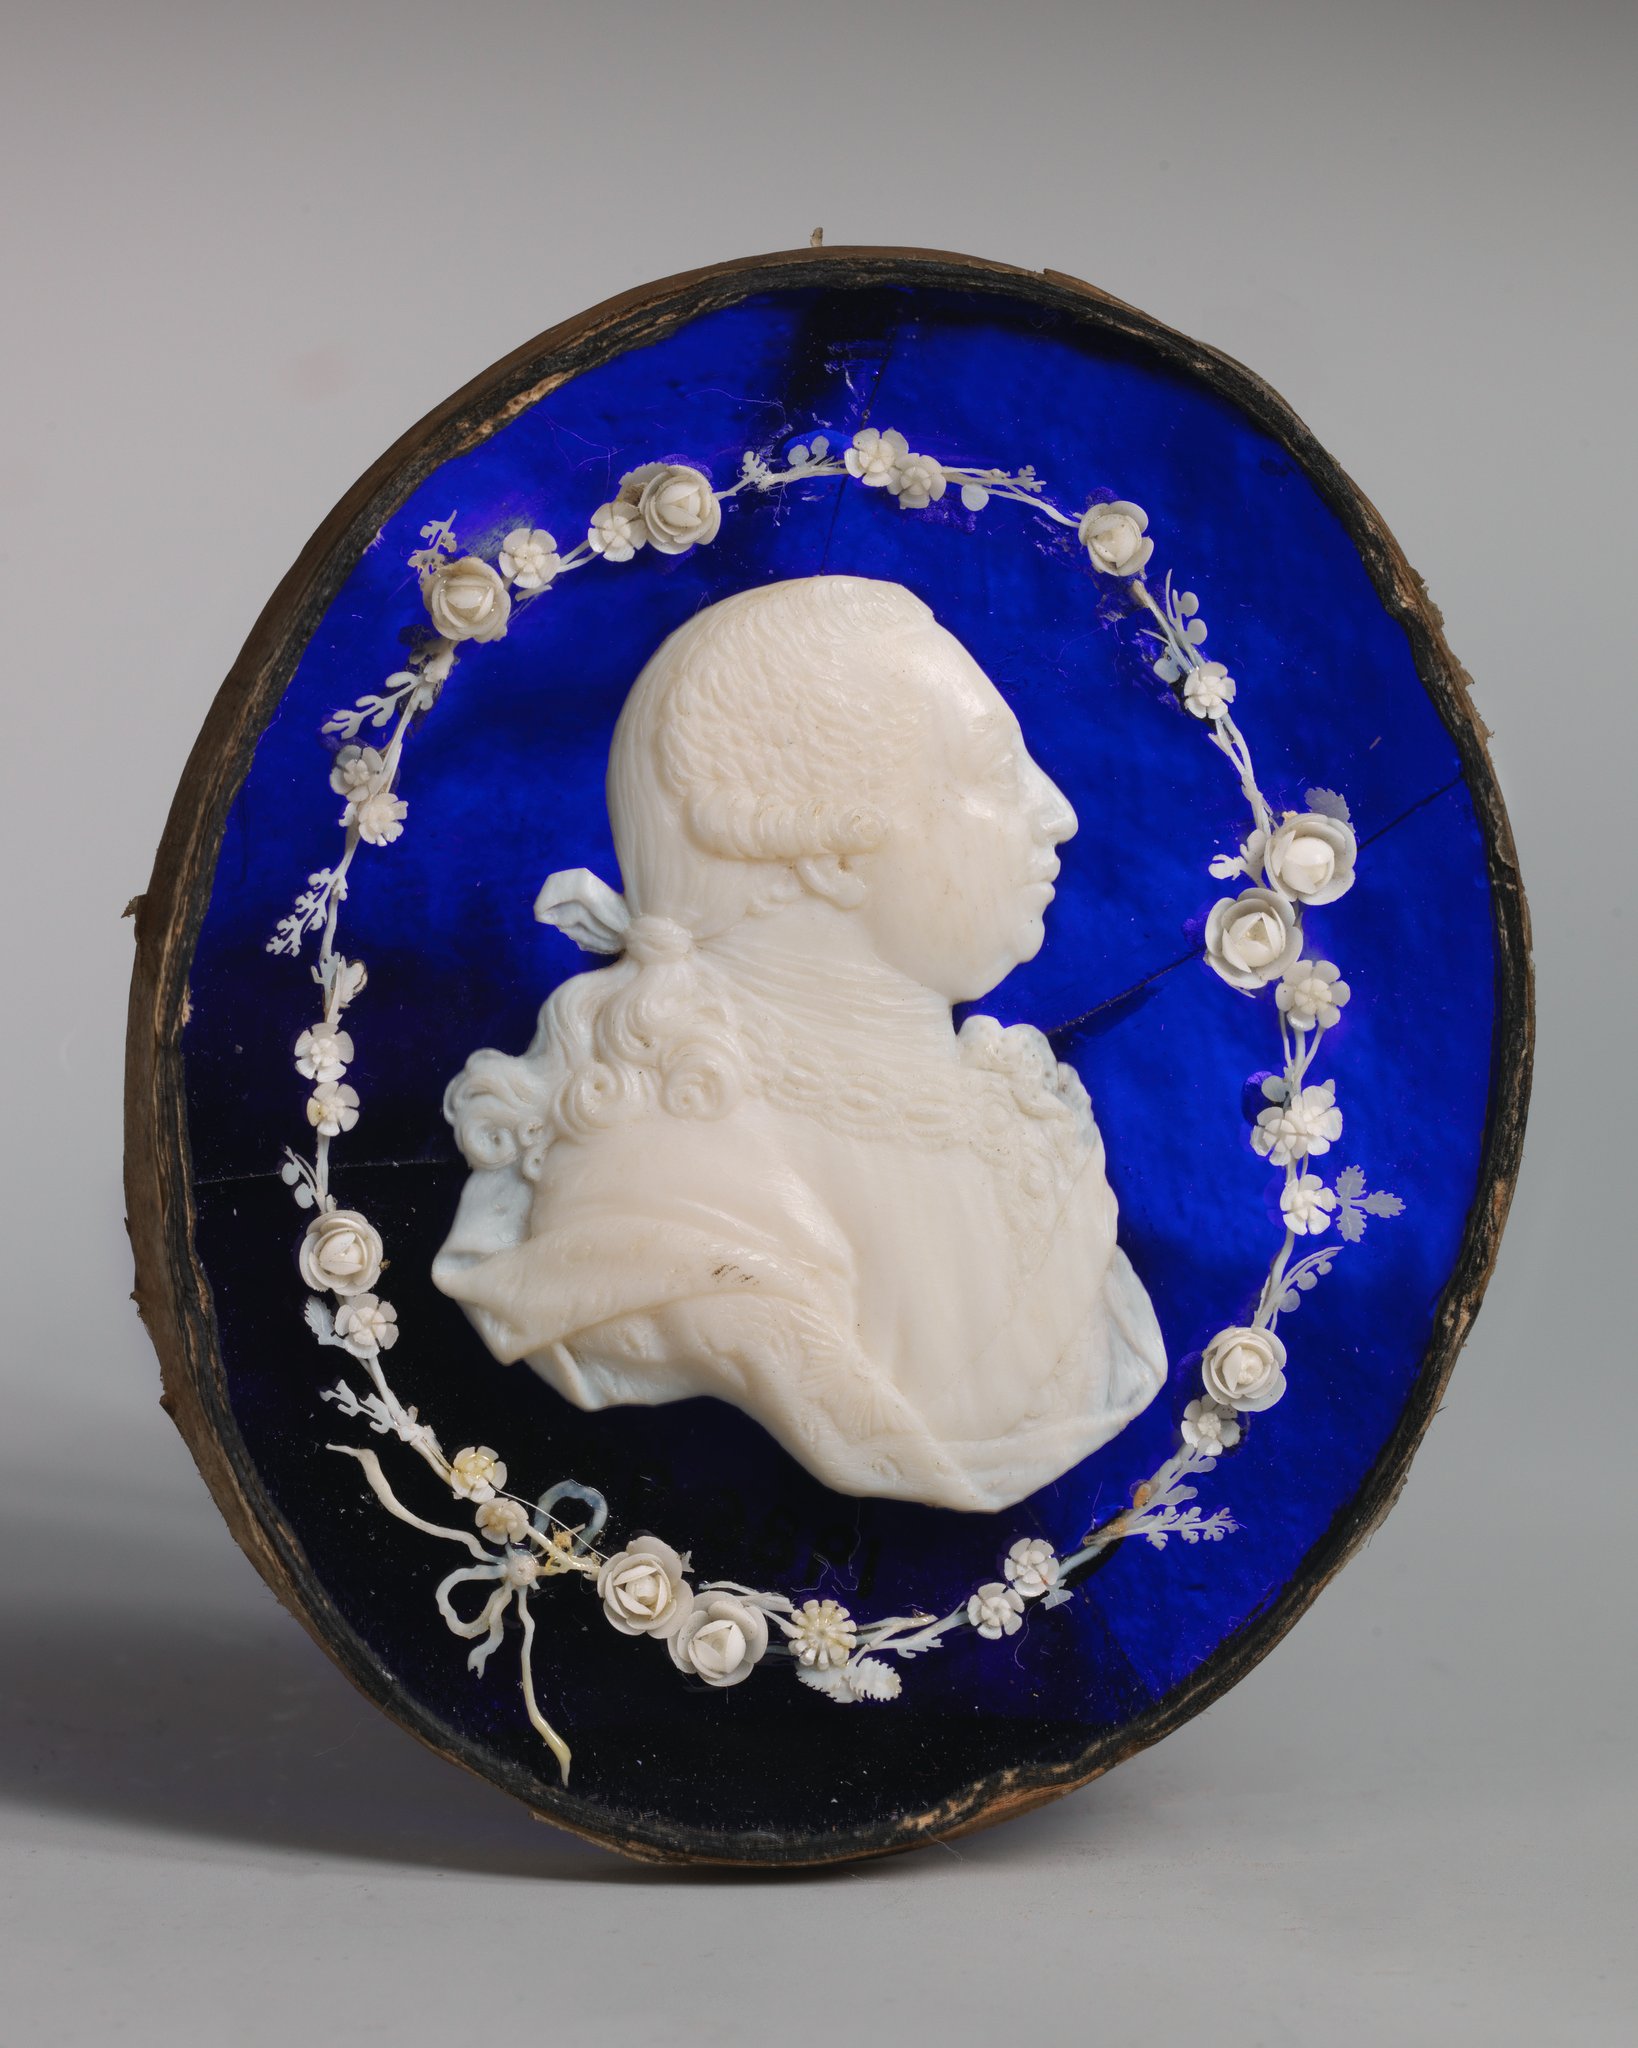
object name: relief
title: George II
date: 1765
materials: glass, ivory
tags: kings,profiles,roses